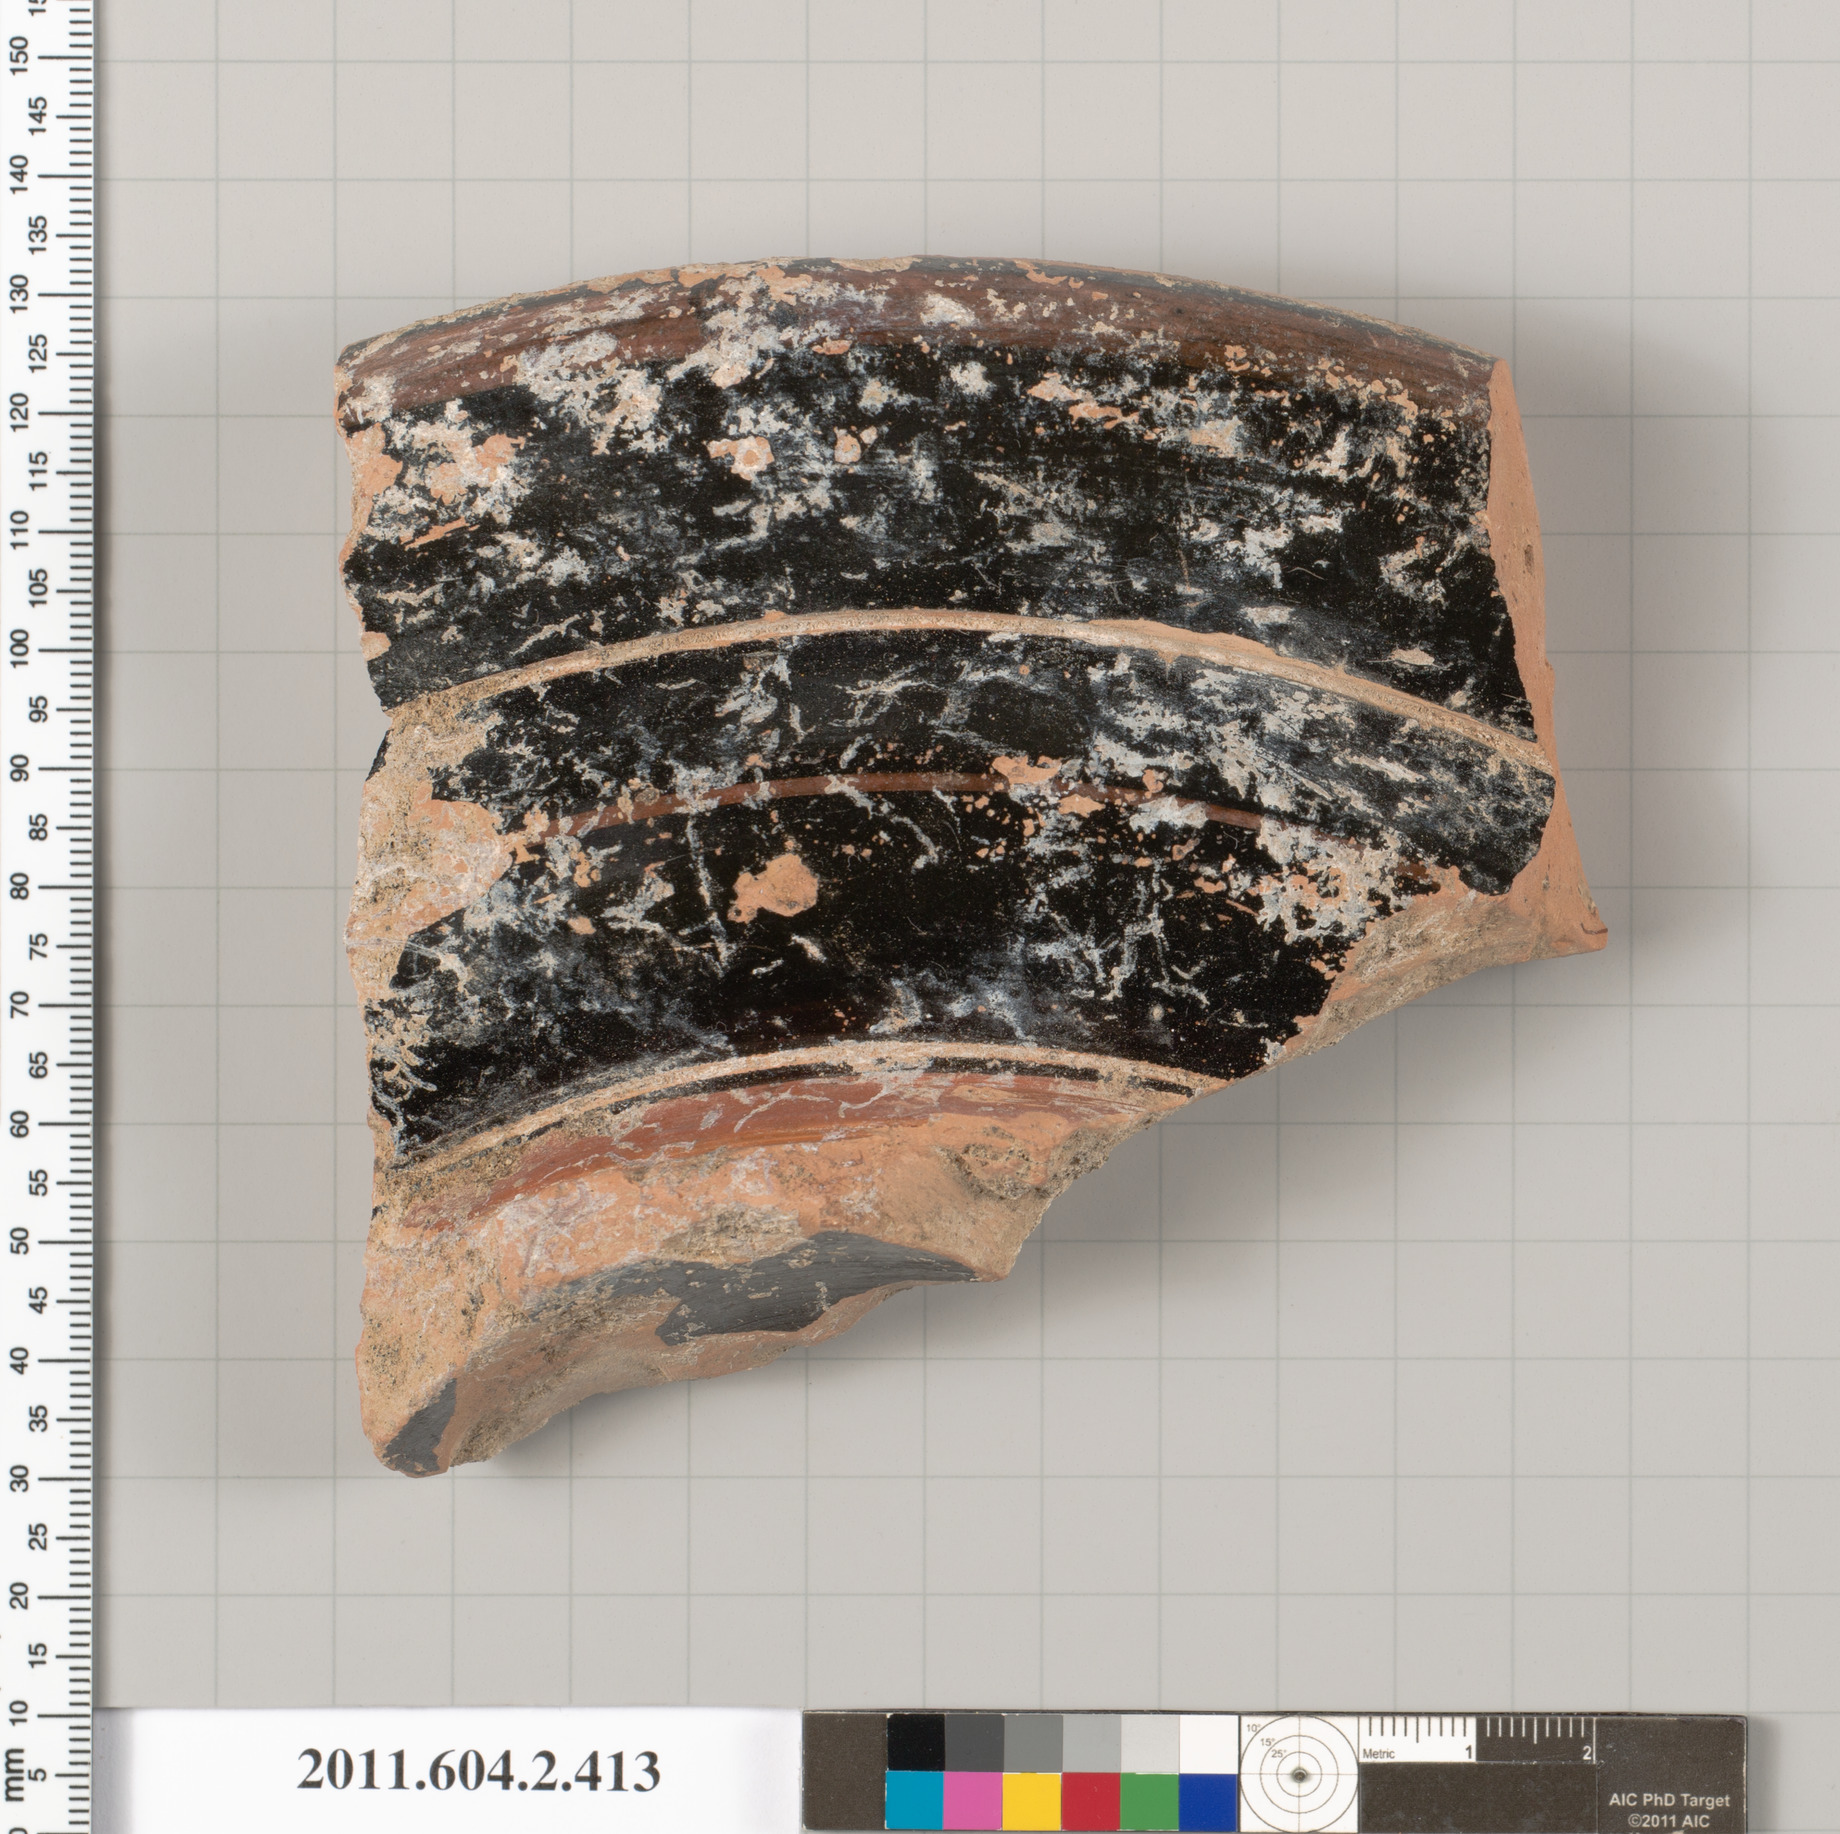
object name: column krater fragment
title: Terracotta fragment of a column-krater (bowl for mixing wine and water)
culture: greek, attic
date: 475-451 BCE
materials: terracotta